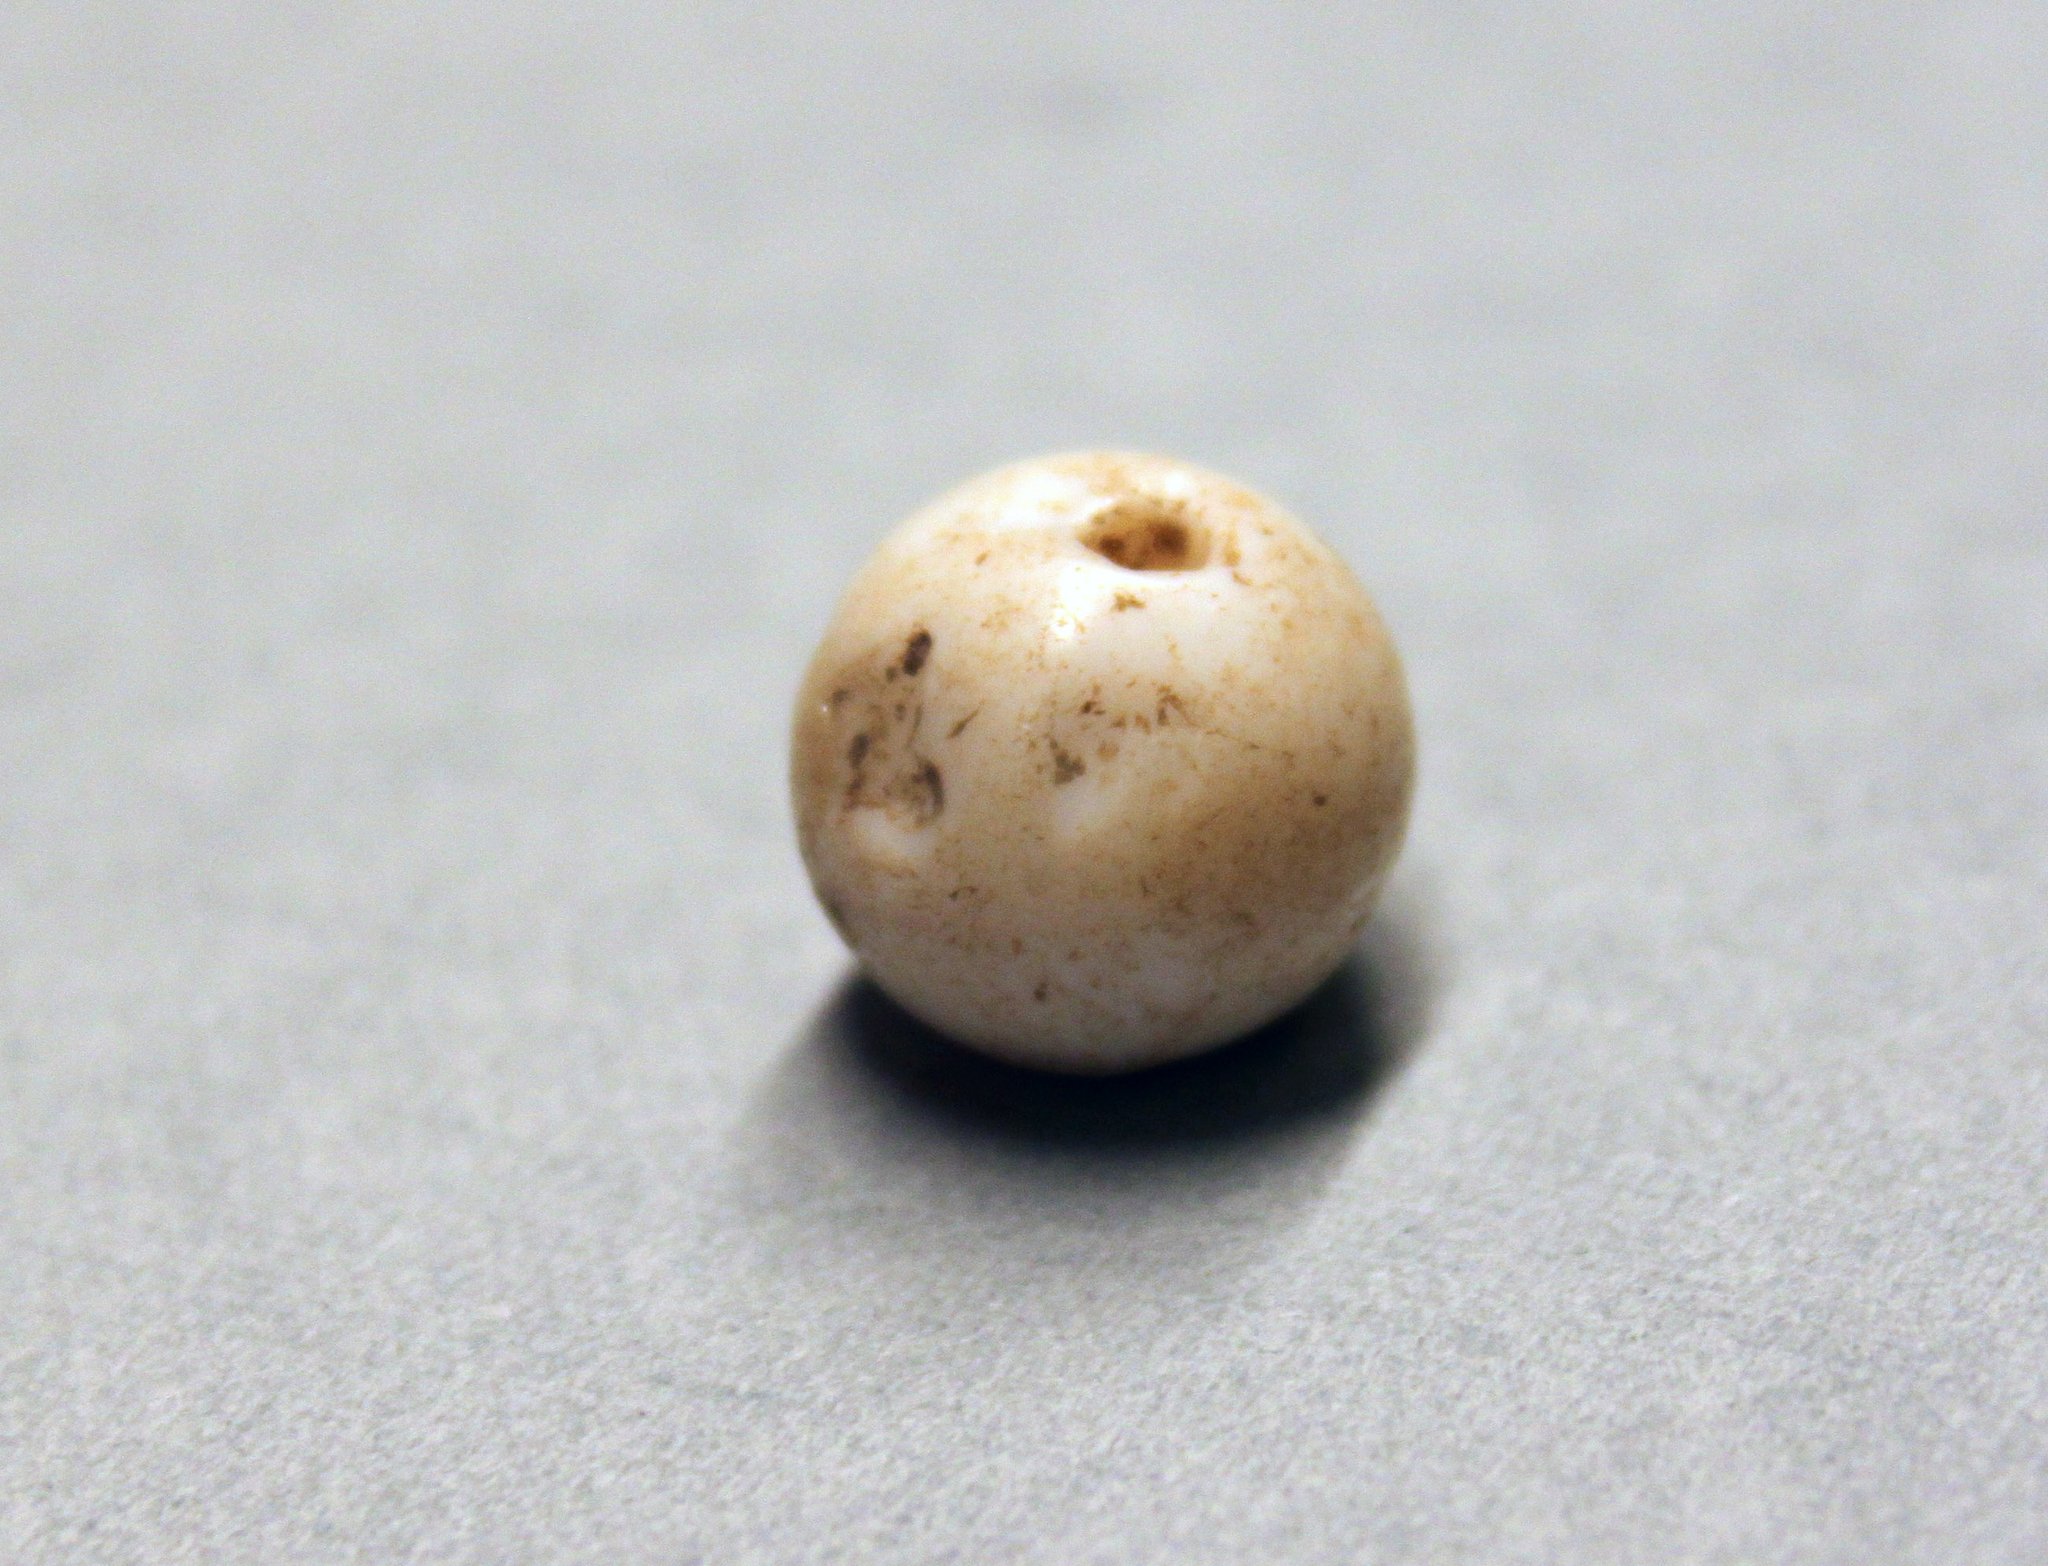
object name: bead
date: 701-1200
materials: stone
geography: iran